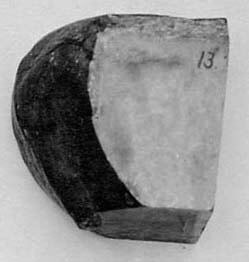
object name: section of boulder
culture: burmese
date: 1902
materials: jade